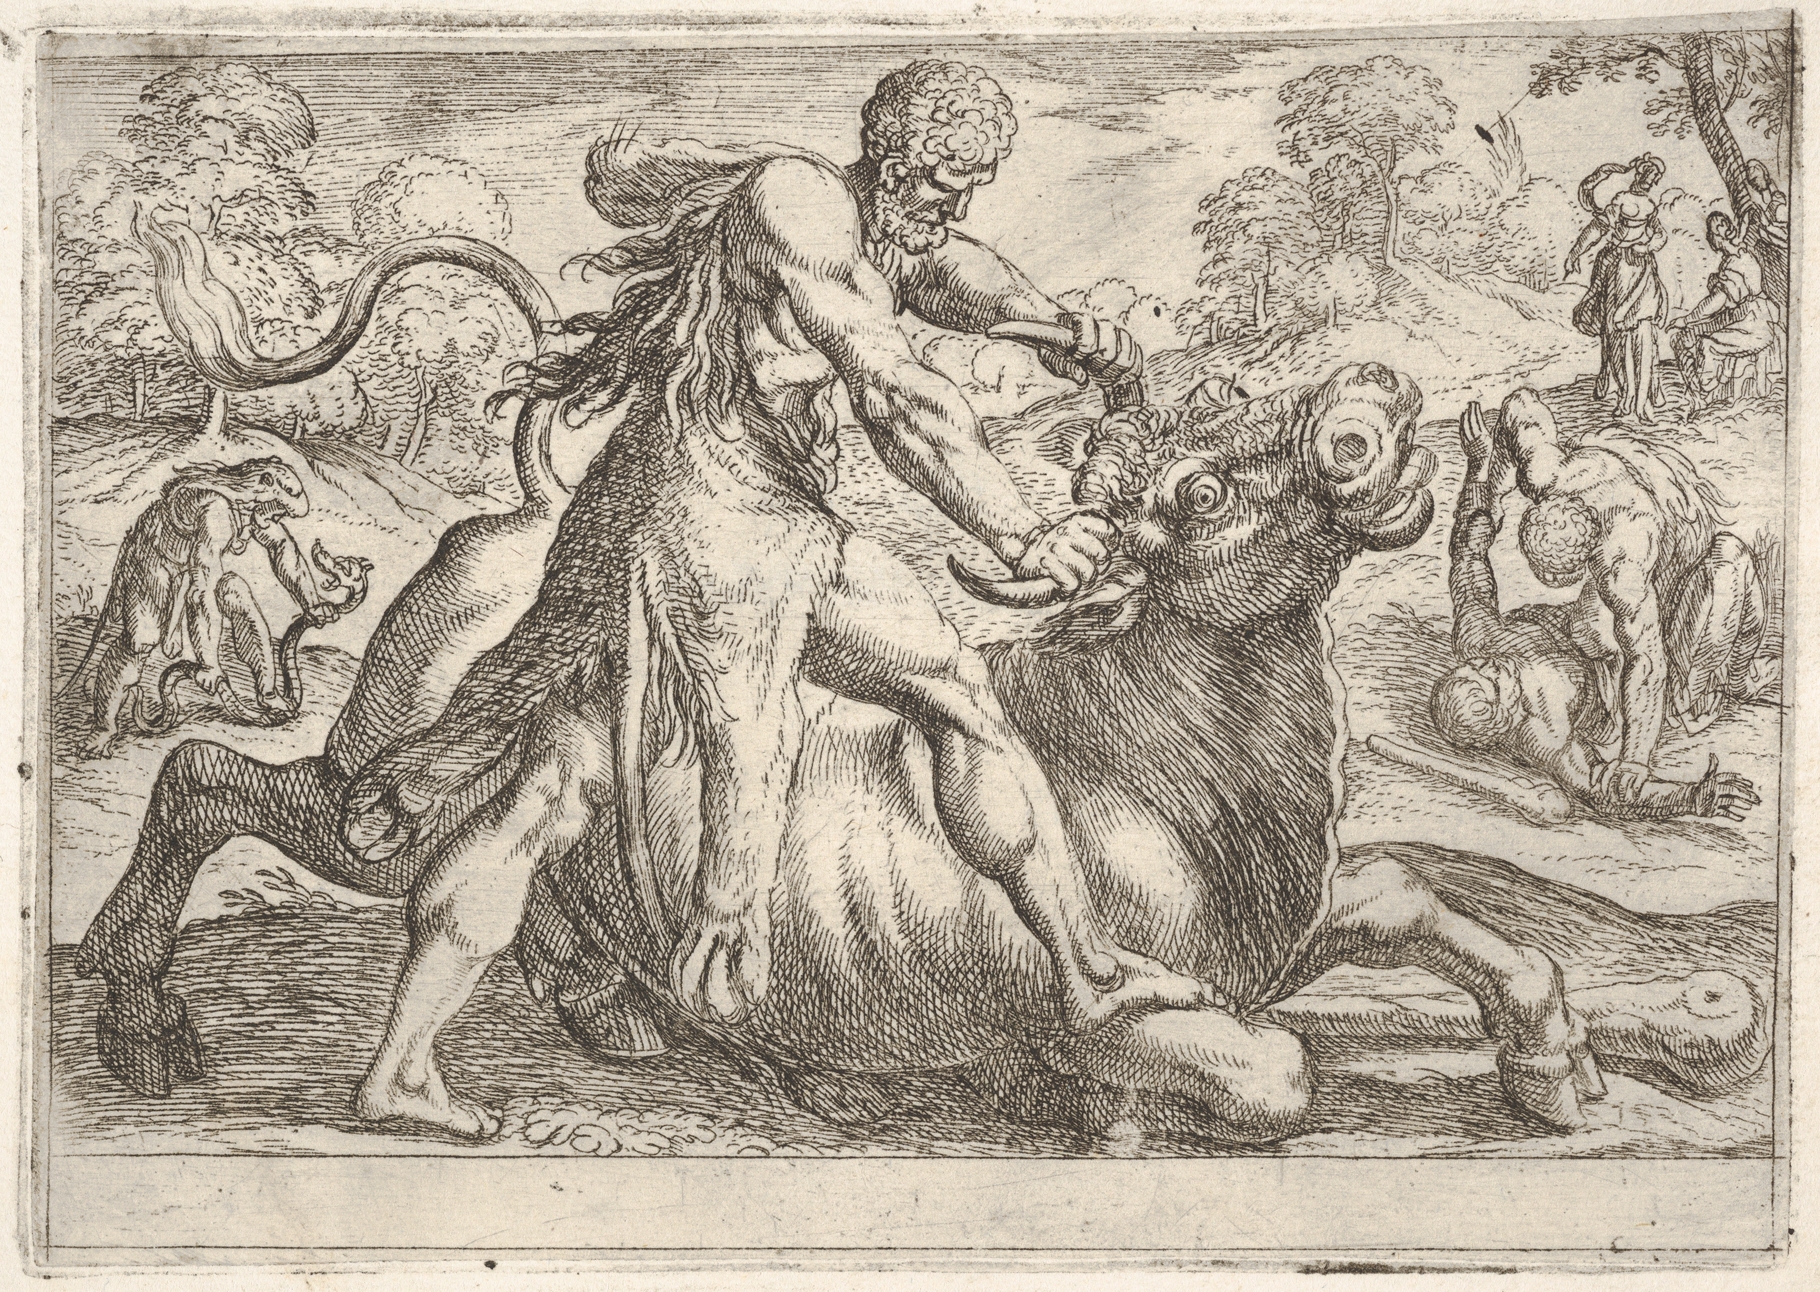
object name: print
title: Hercules and Achelous, from "The Labors of Hercules"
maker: antonio tempesta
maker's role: artist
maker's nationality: italian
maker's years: 1555-1630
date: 1608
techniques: etching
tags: men,hercules,bulls,serpents